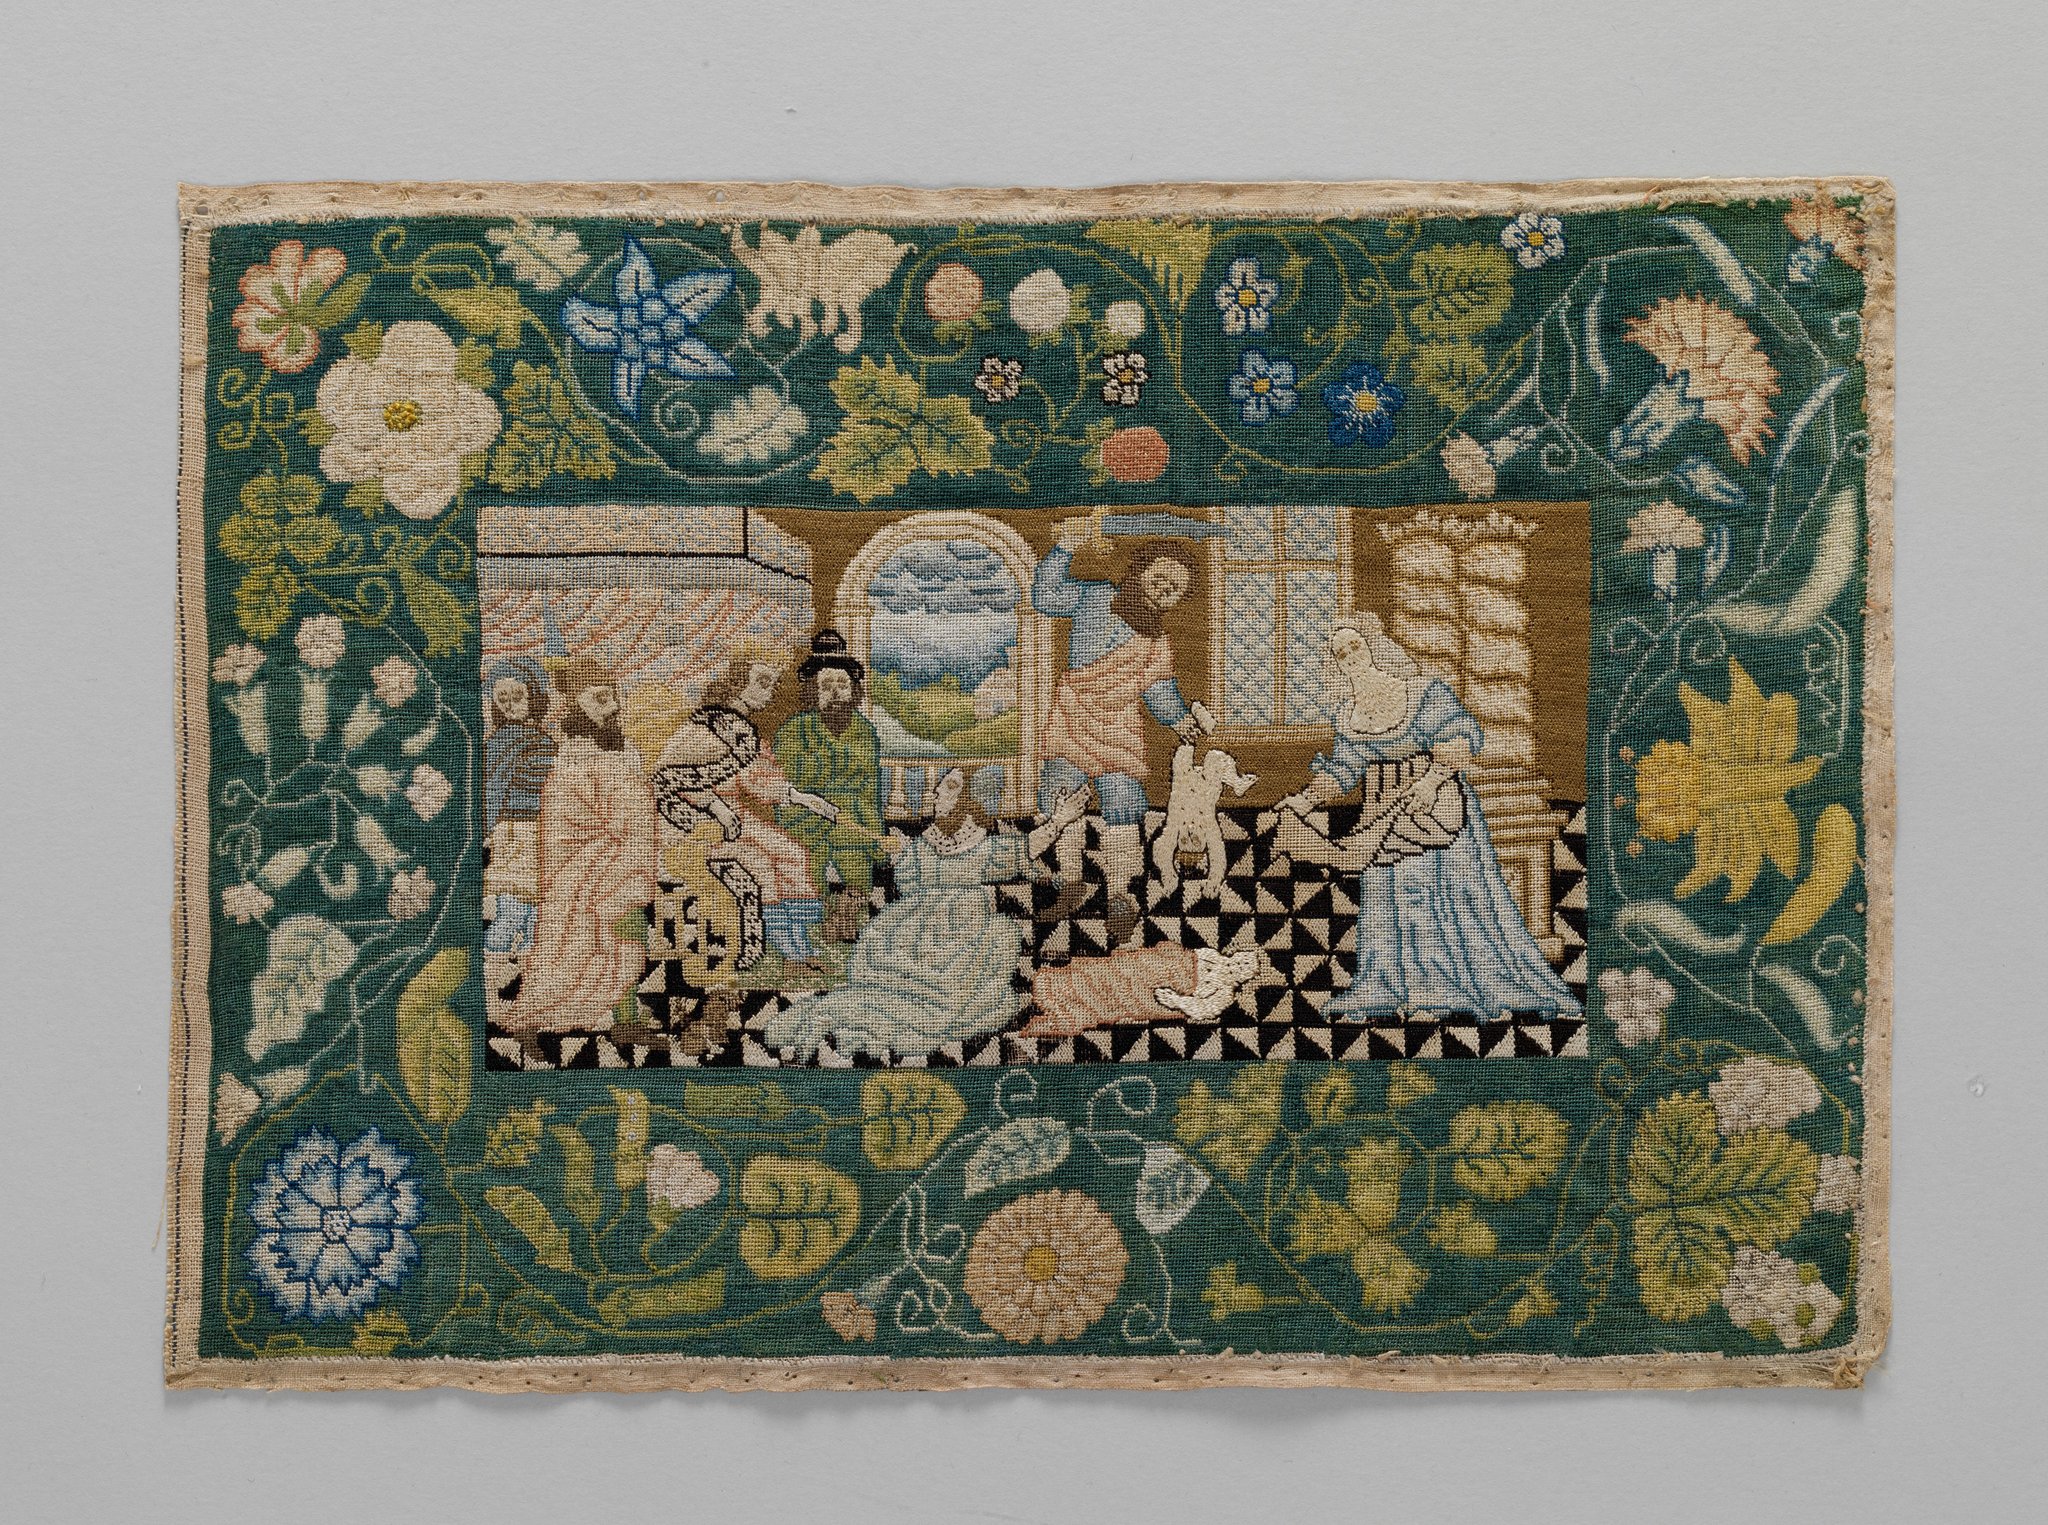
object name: embroidered picture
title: Judgement of Solomon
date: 1634-1666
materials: canvas, thread, steel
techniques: stitching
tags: swords,infants,men,women,flowers